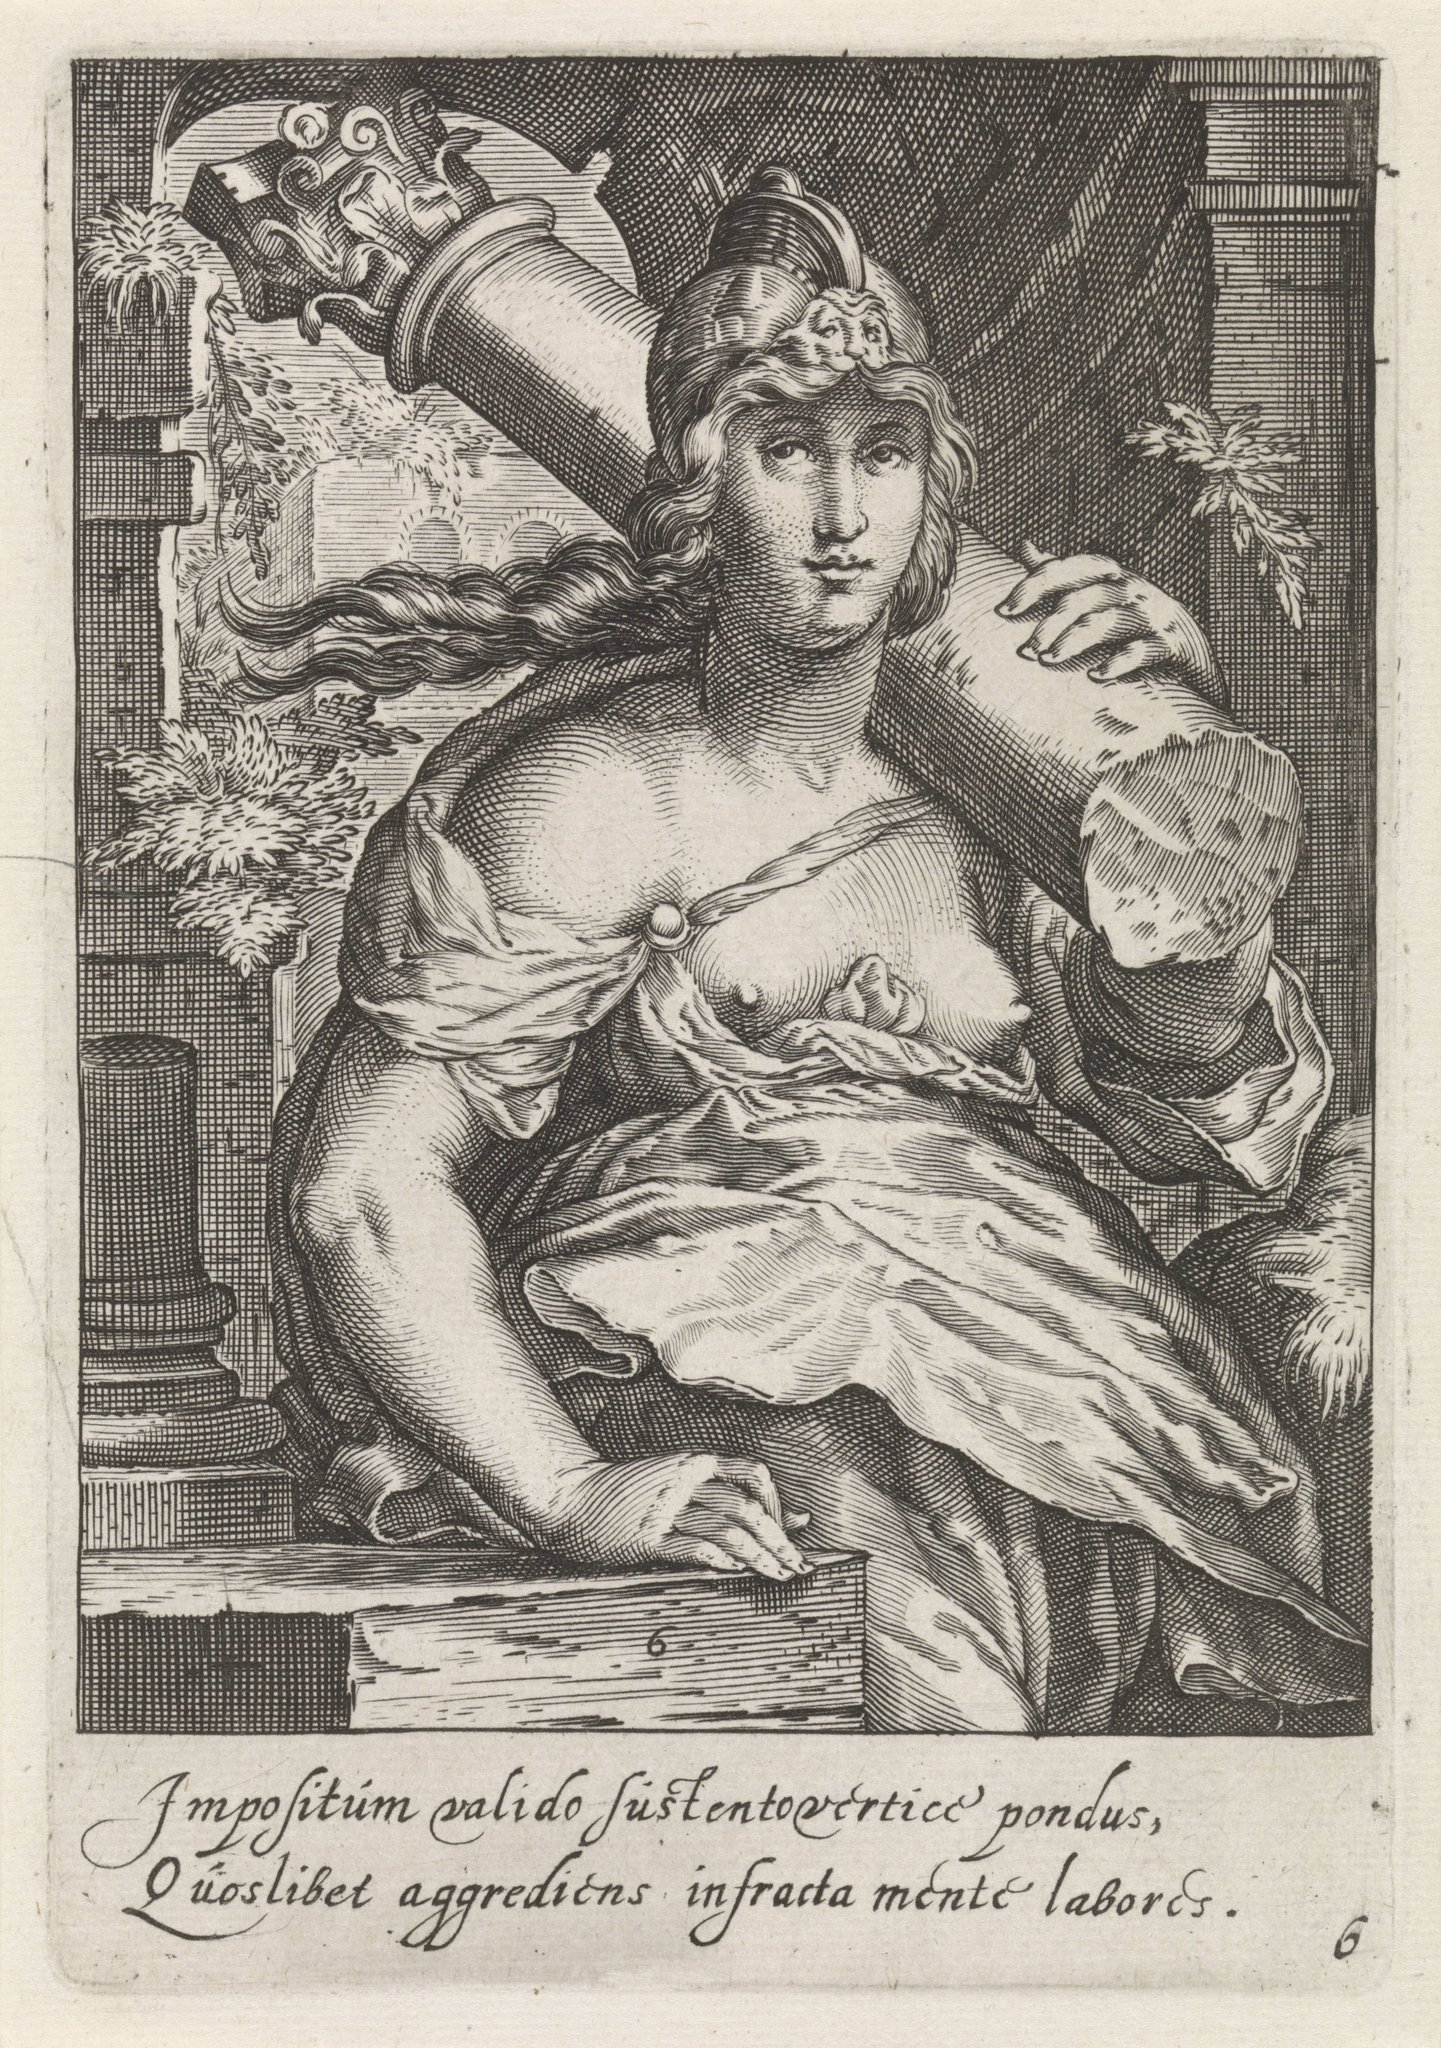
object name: print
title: Kracht (Fortitudo)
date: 1601-1652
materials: paper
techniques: engraving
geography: amsterdam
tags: fortitude, 'fortitudo' ~ one of the four cardinal virtues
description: Een vrouwenfiguur met een een zuil over haar schouder als de personificatie van kracht (fortitudo).